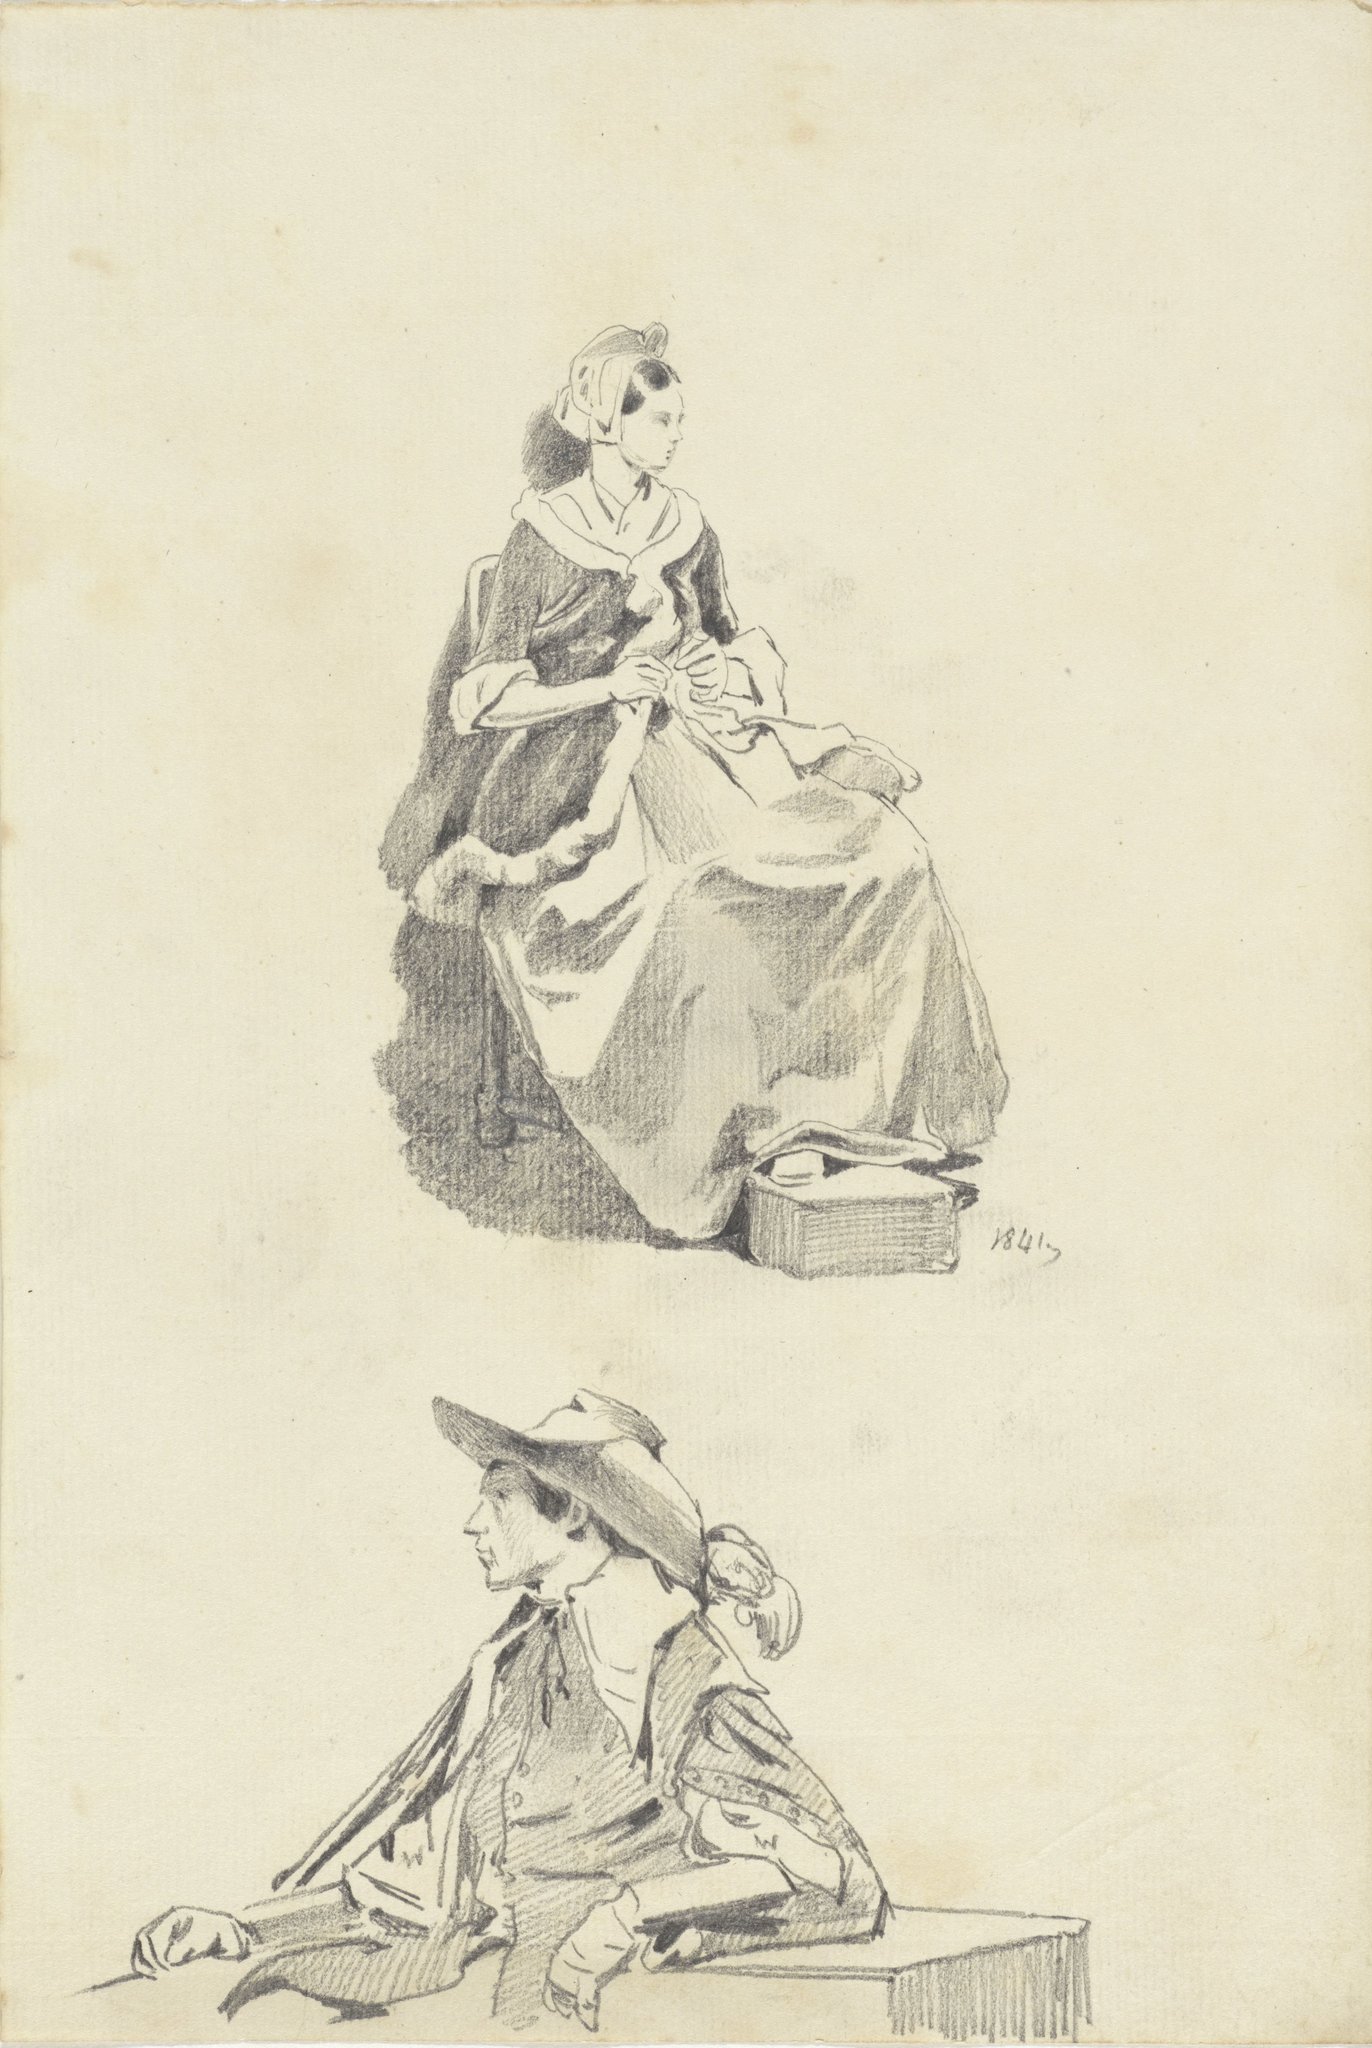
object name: drawing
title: Zittende man en vrouw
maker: pieter van loon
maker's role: draughtsman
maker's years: 1801-1873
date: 1841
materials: paper, pencil